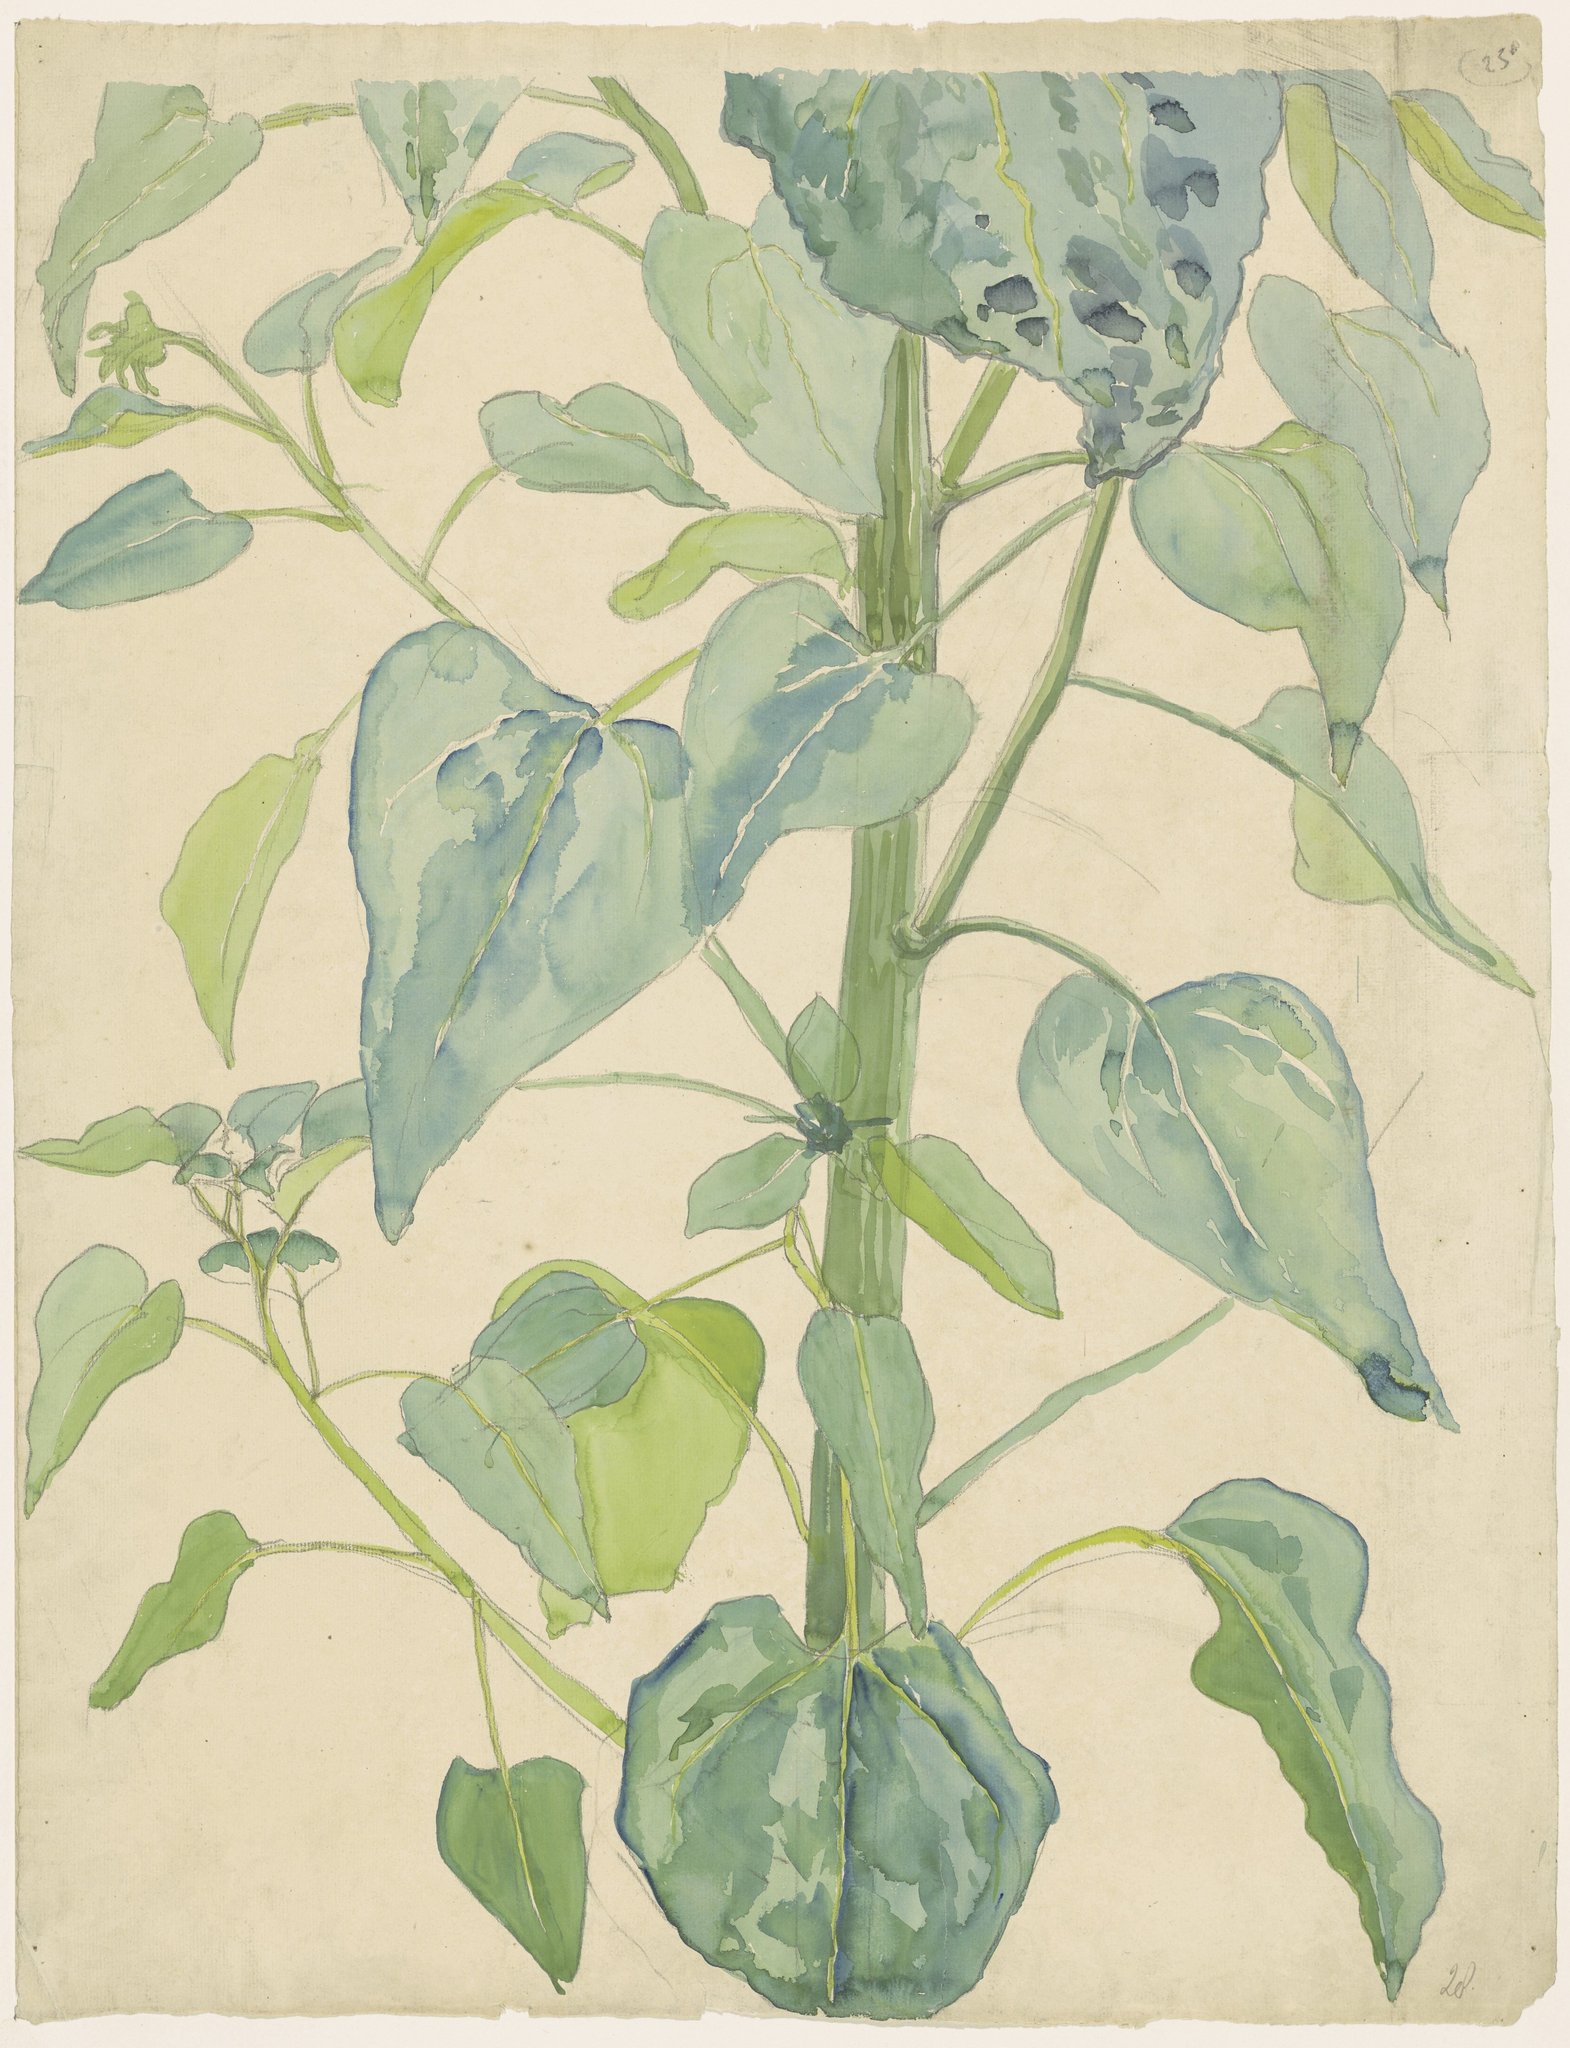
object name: drawing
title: Stalk and Leaves of a Sunflower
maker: martinus van andringa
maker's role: draughtsman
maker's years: 1864-1918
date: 1874-1918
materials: paper, pencil, watercolor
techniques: brush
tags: flowers: sunflower (+ leaves, putting forth leaves)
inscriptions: inscription: ‘28.’, inscription: ‘250’, inscription: ‘AR 8/30’, collector's mark: Lugt 2228, collector's mark: Lugt 2760